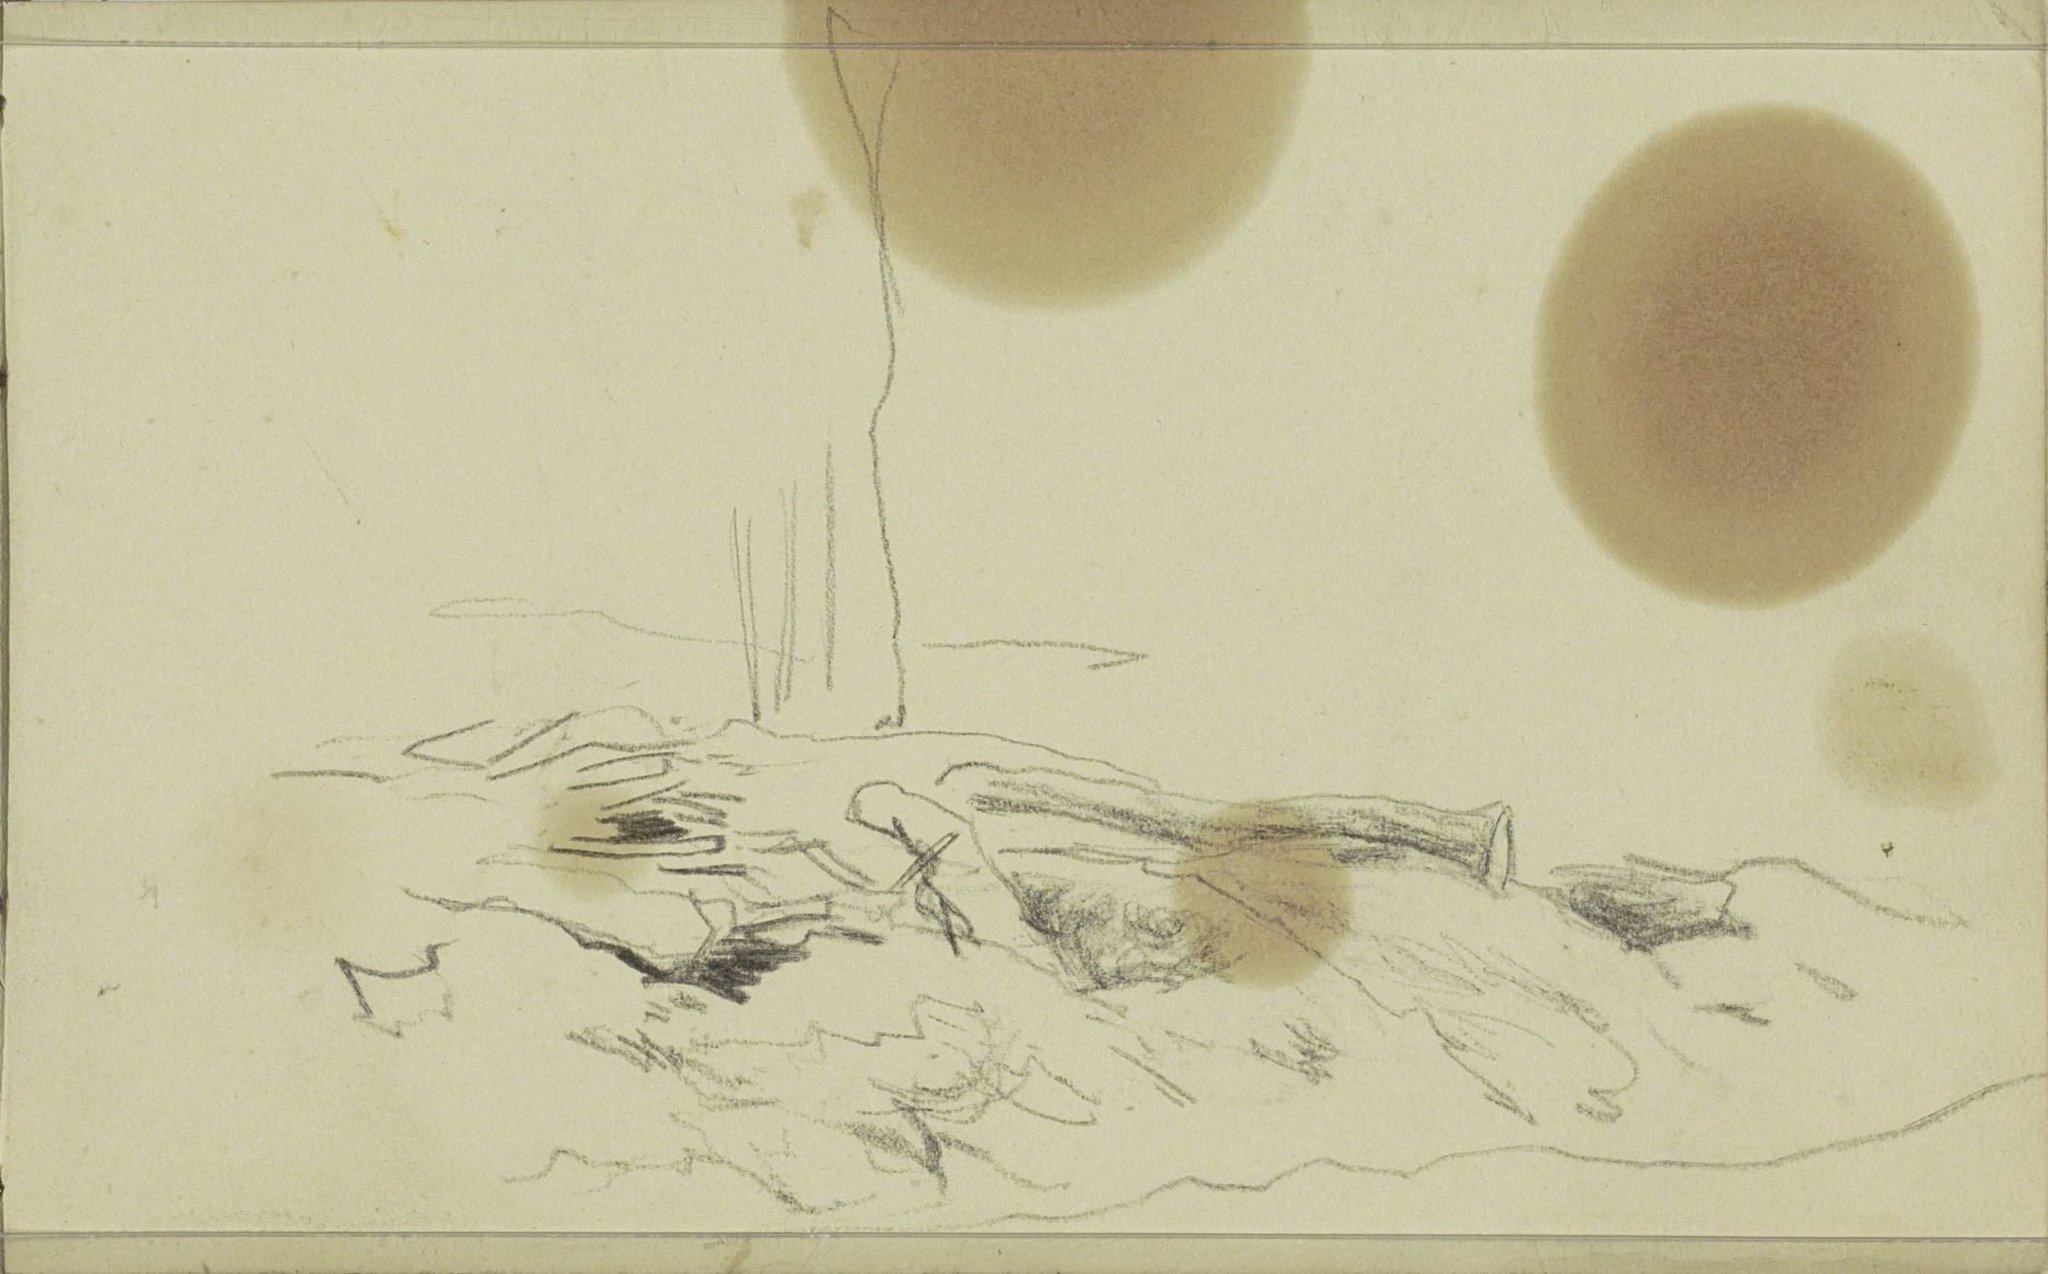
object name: sketchbook leaf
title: Takken op een heuvel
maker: anton mauve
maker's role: draughtsman, painter, print maker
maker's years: 1838-1888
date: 1848-1888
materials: chalk, paper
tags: trees (+ branch, stick)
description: Blad 38 recto uit een schetsboek met 44 bladen.